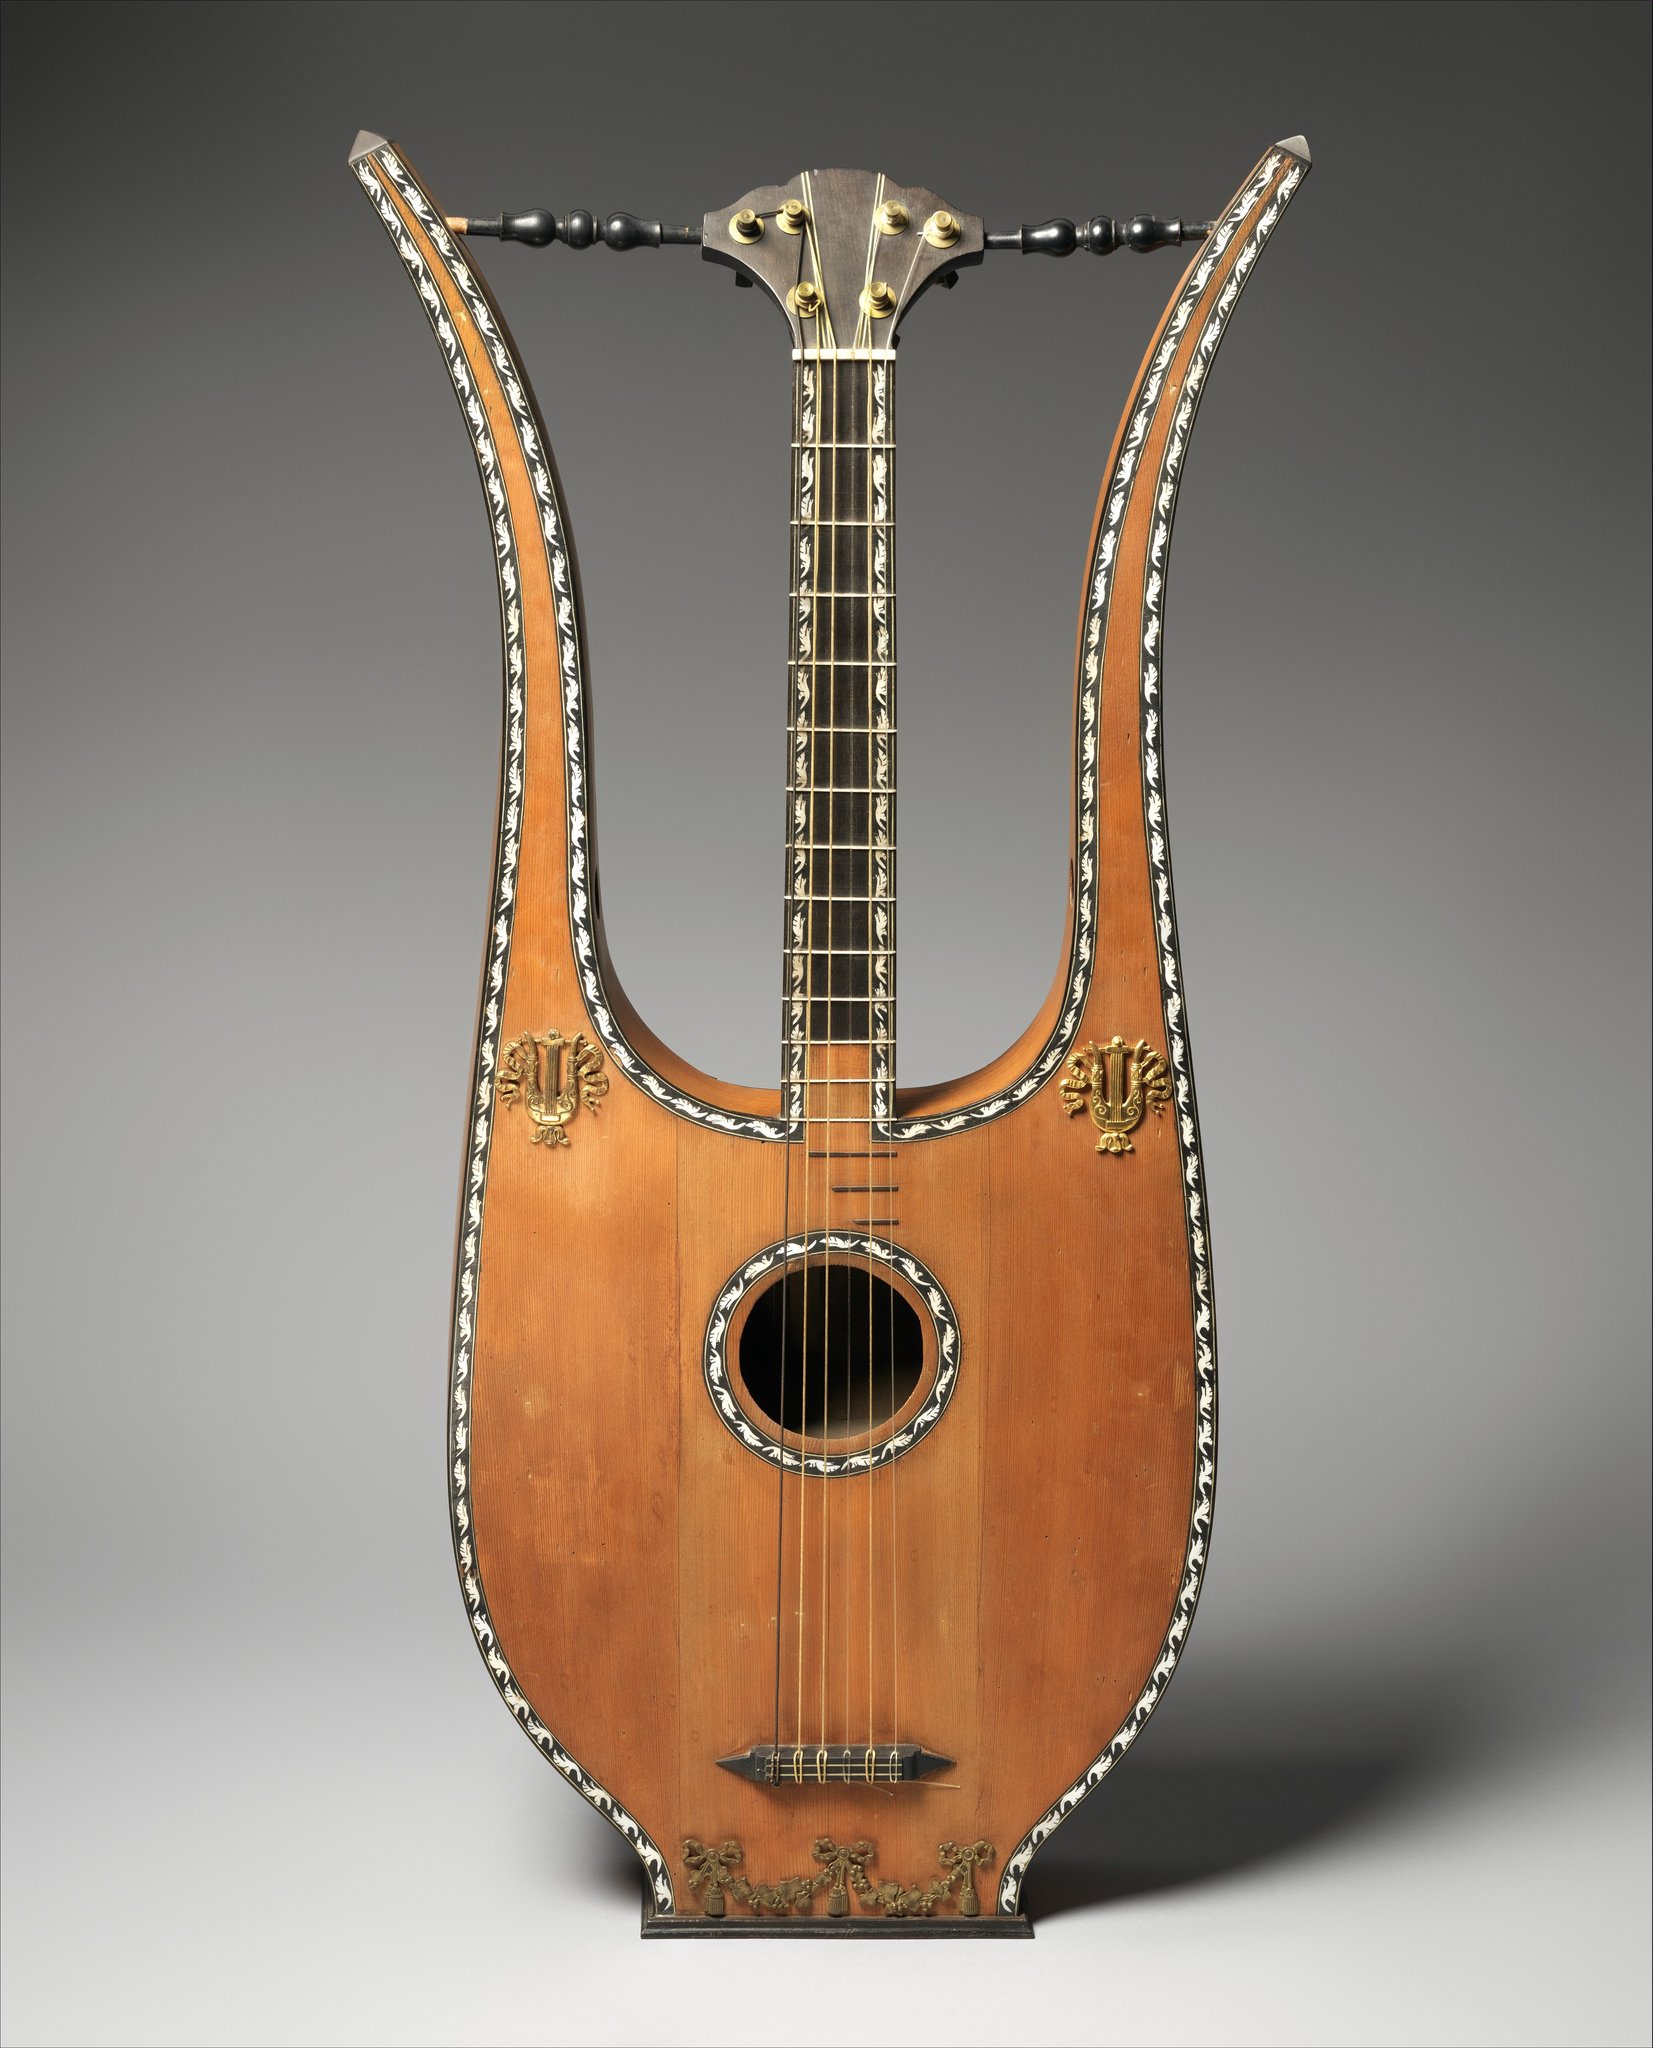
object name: lyre guitar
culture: french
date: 1801-1833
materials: brass, wood, ivory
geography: france